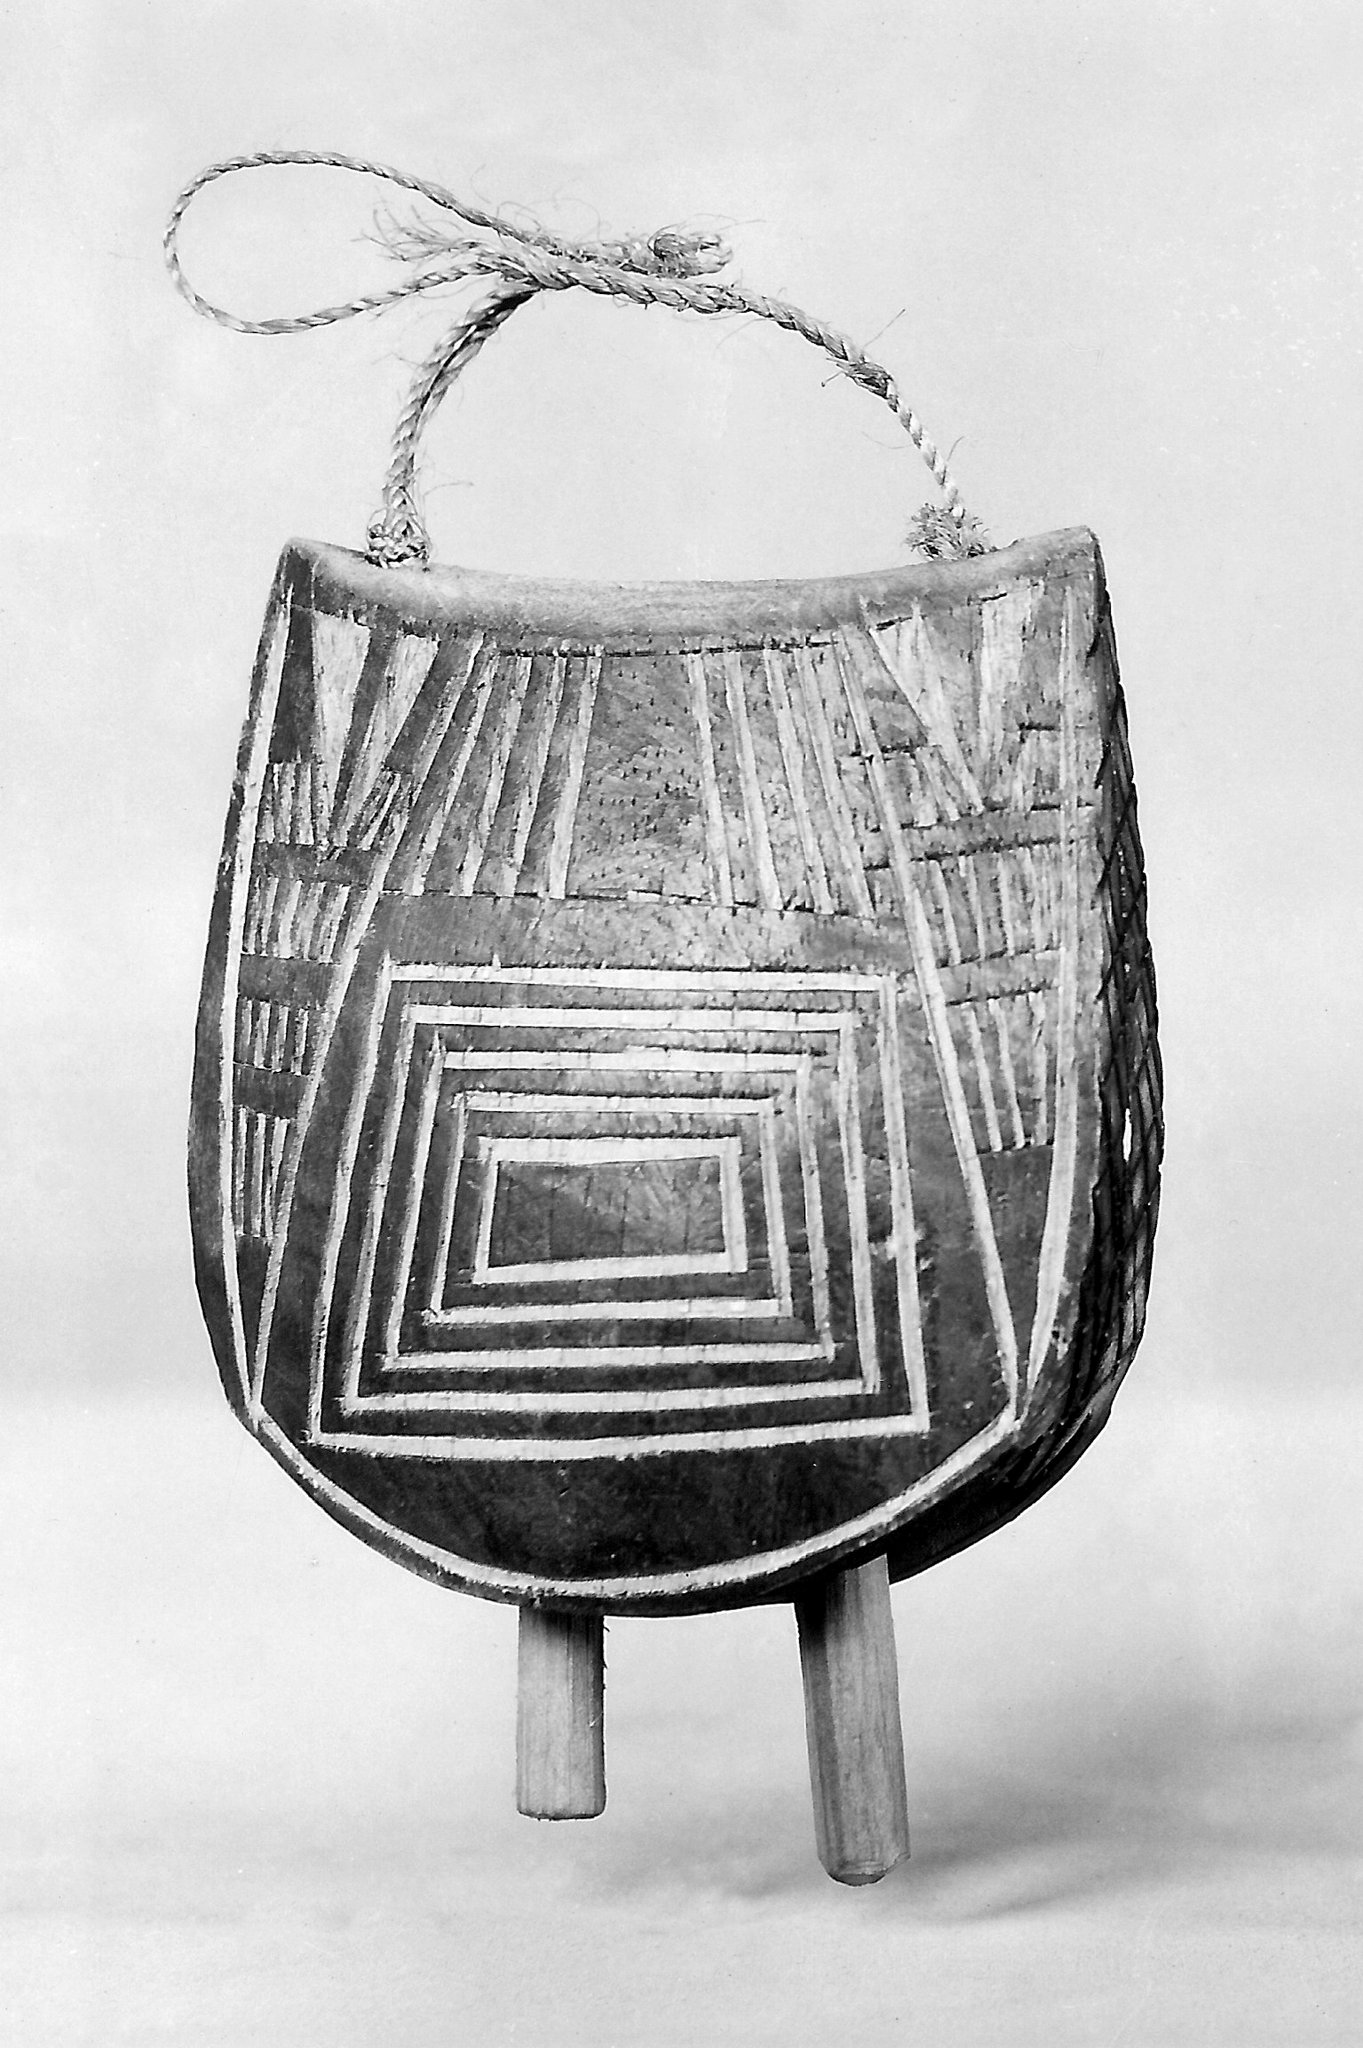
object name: ngonge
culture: central african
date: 1867-1900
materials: wood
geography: congo